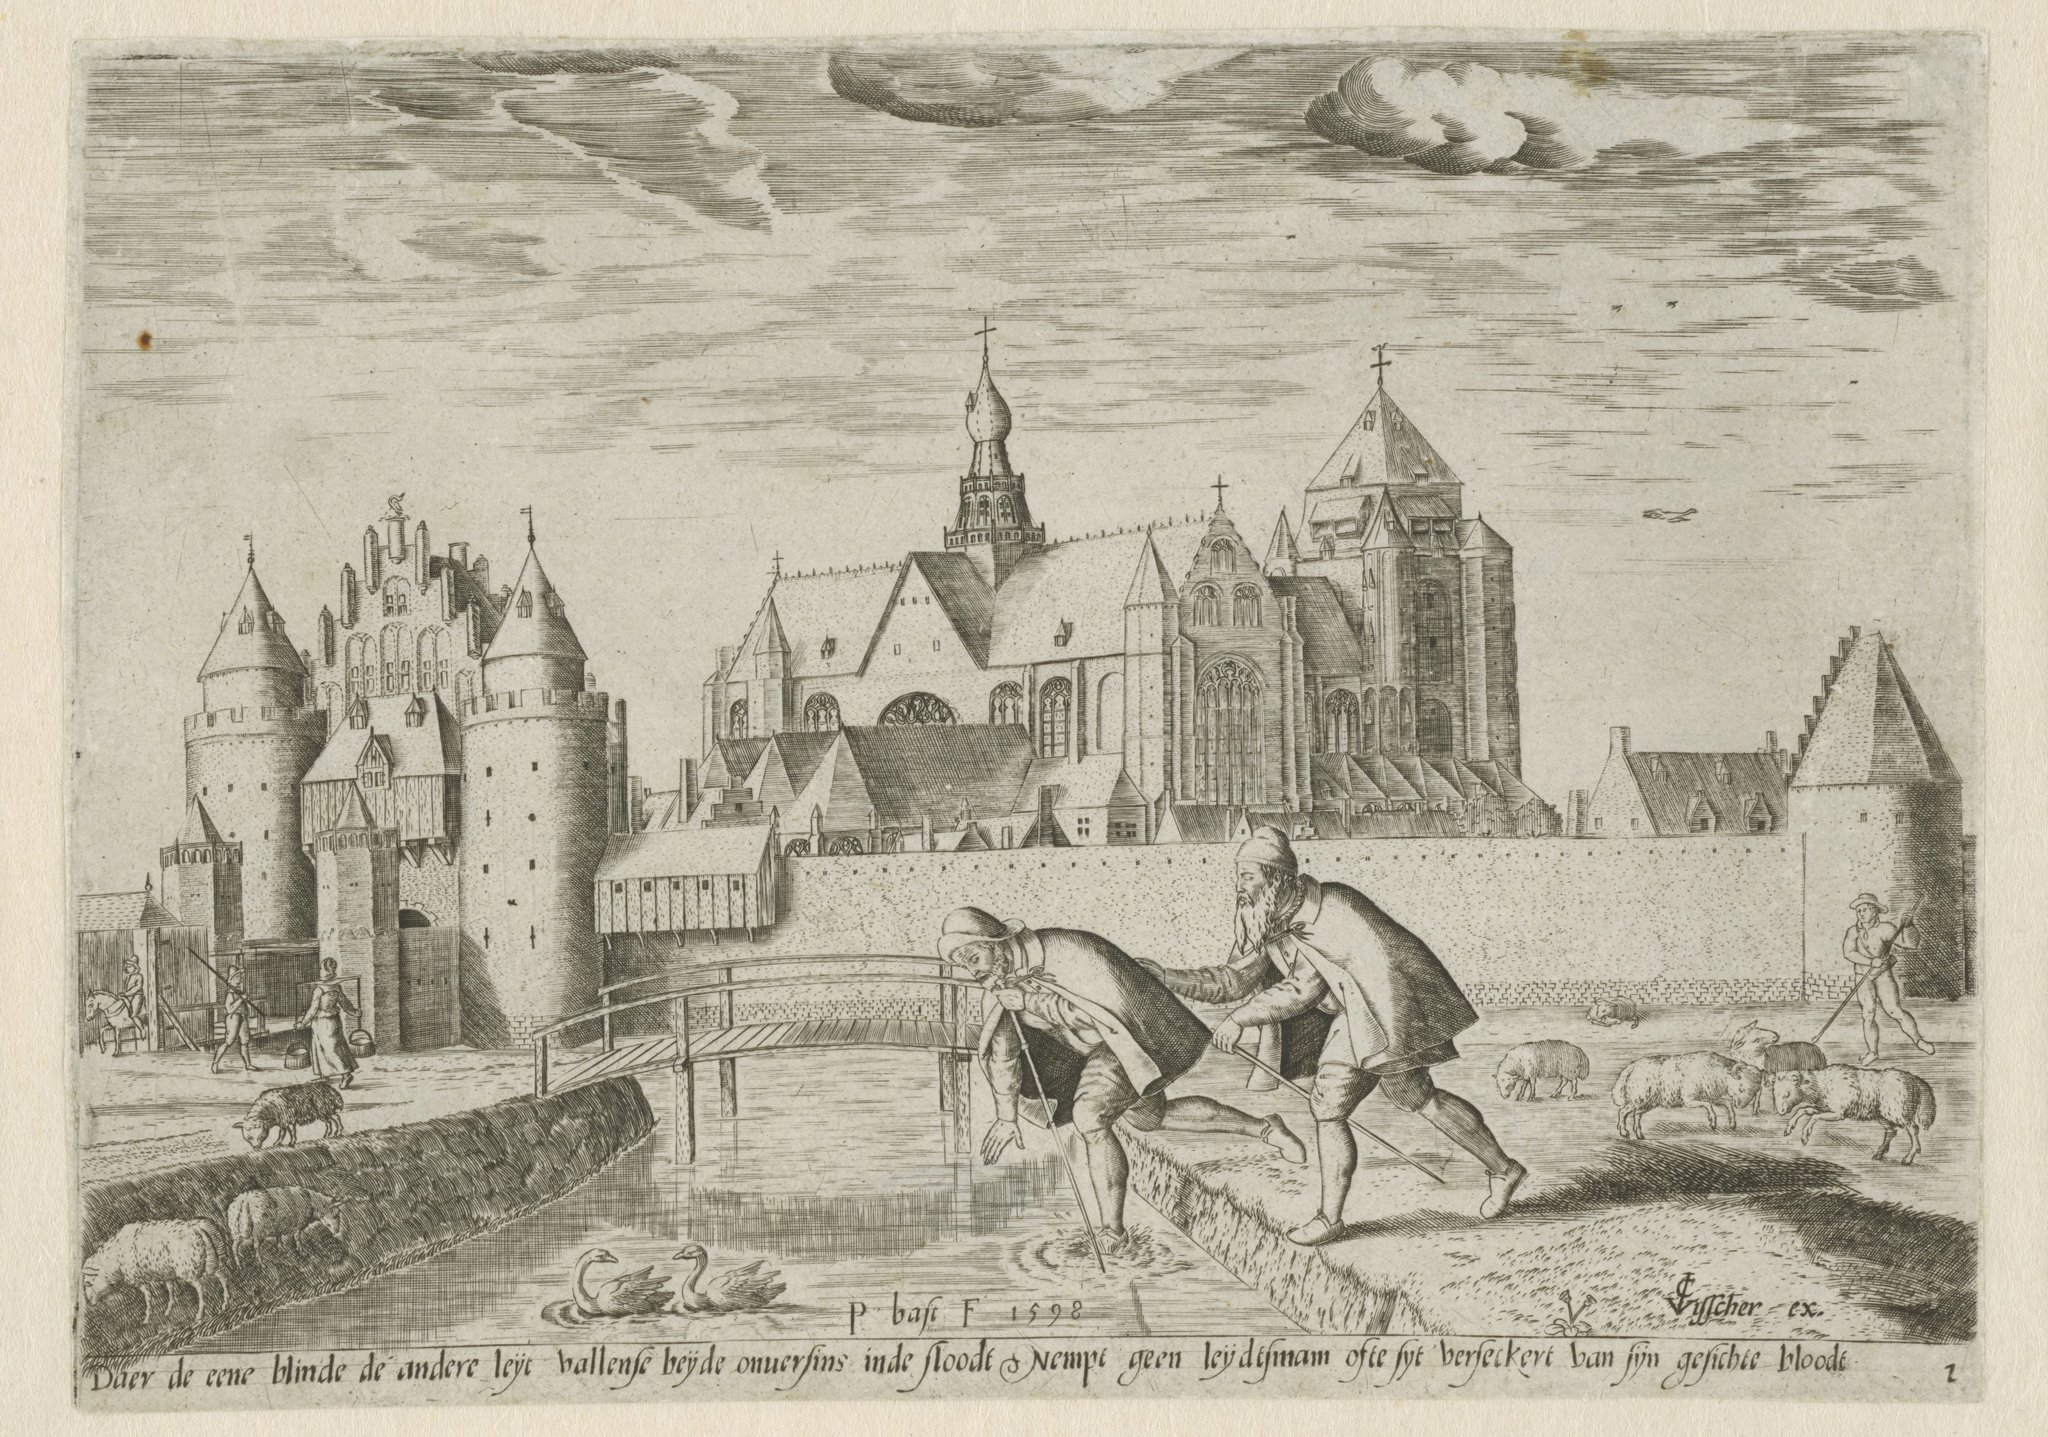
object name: print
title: Landschappen met bijbelse scènes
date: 1598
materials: paper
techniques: engraving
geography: amsterdam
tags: the blind leading the blind (matthew 15:14), proverbs, sayings, etc., city-walls, city-gate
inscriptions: collector's mark: Lugt 2228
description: Gezicht op de stadsmuur van Veere waarboven de grote kerk torent. Links de stadspoort. Op de voorgrond het spreekwoord: de ene blinde leidt de andere: twee blinde mannen lopen achter elkaar aan. De voorste loopt het water van de gracht in, de ander volgt. Rechts een herder met wat schapen.